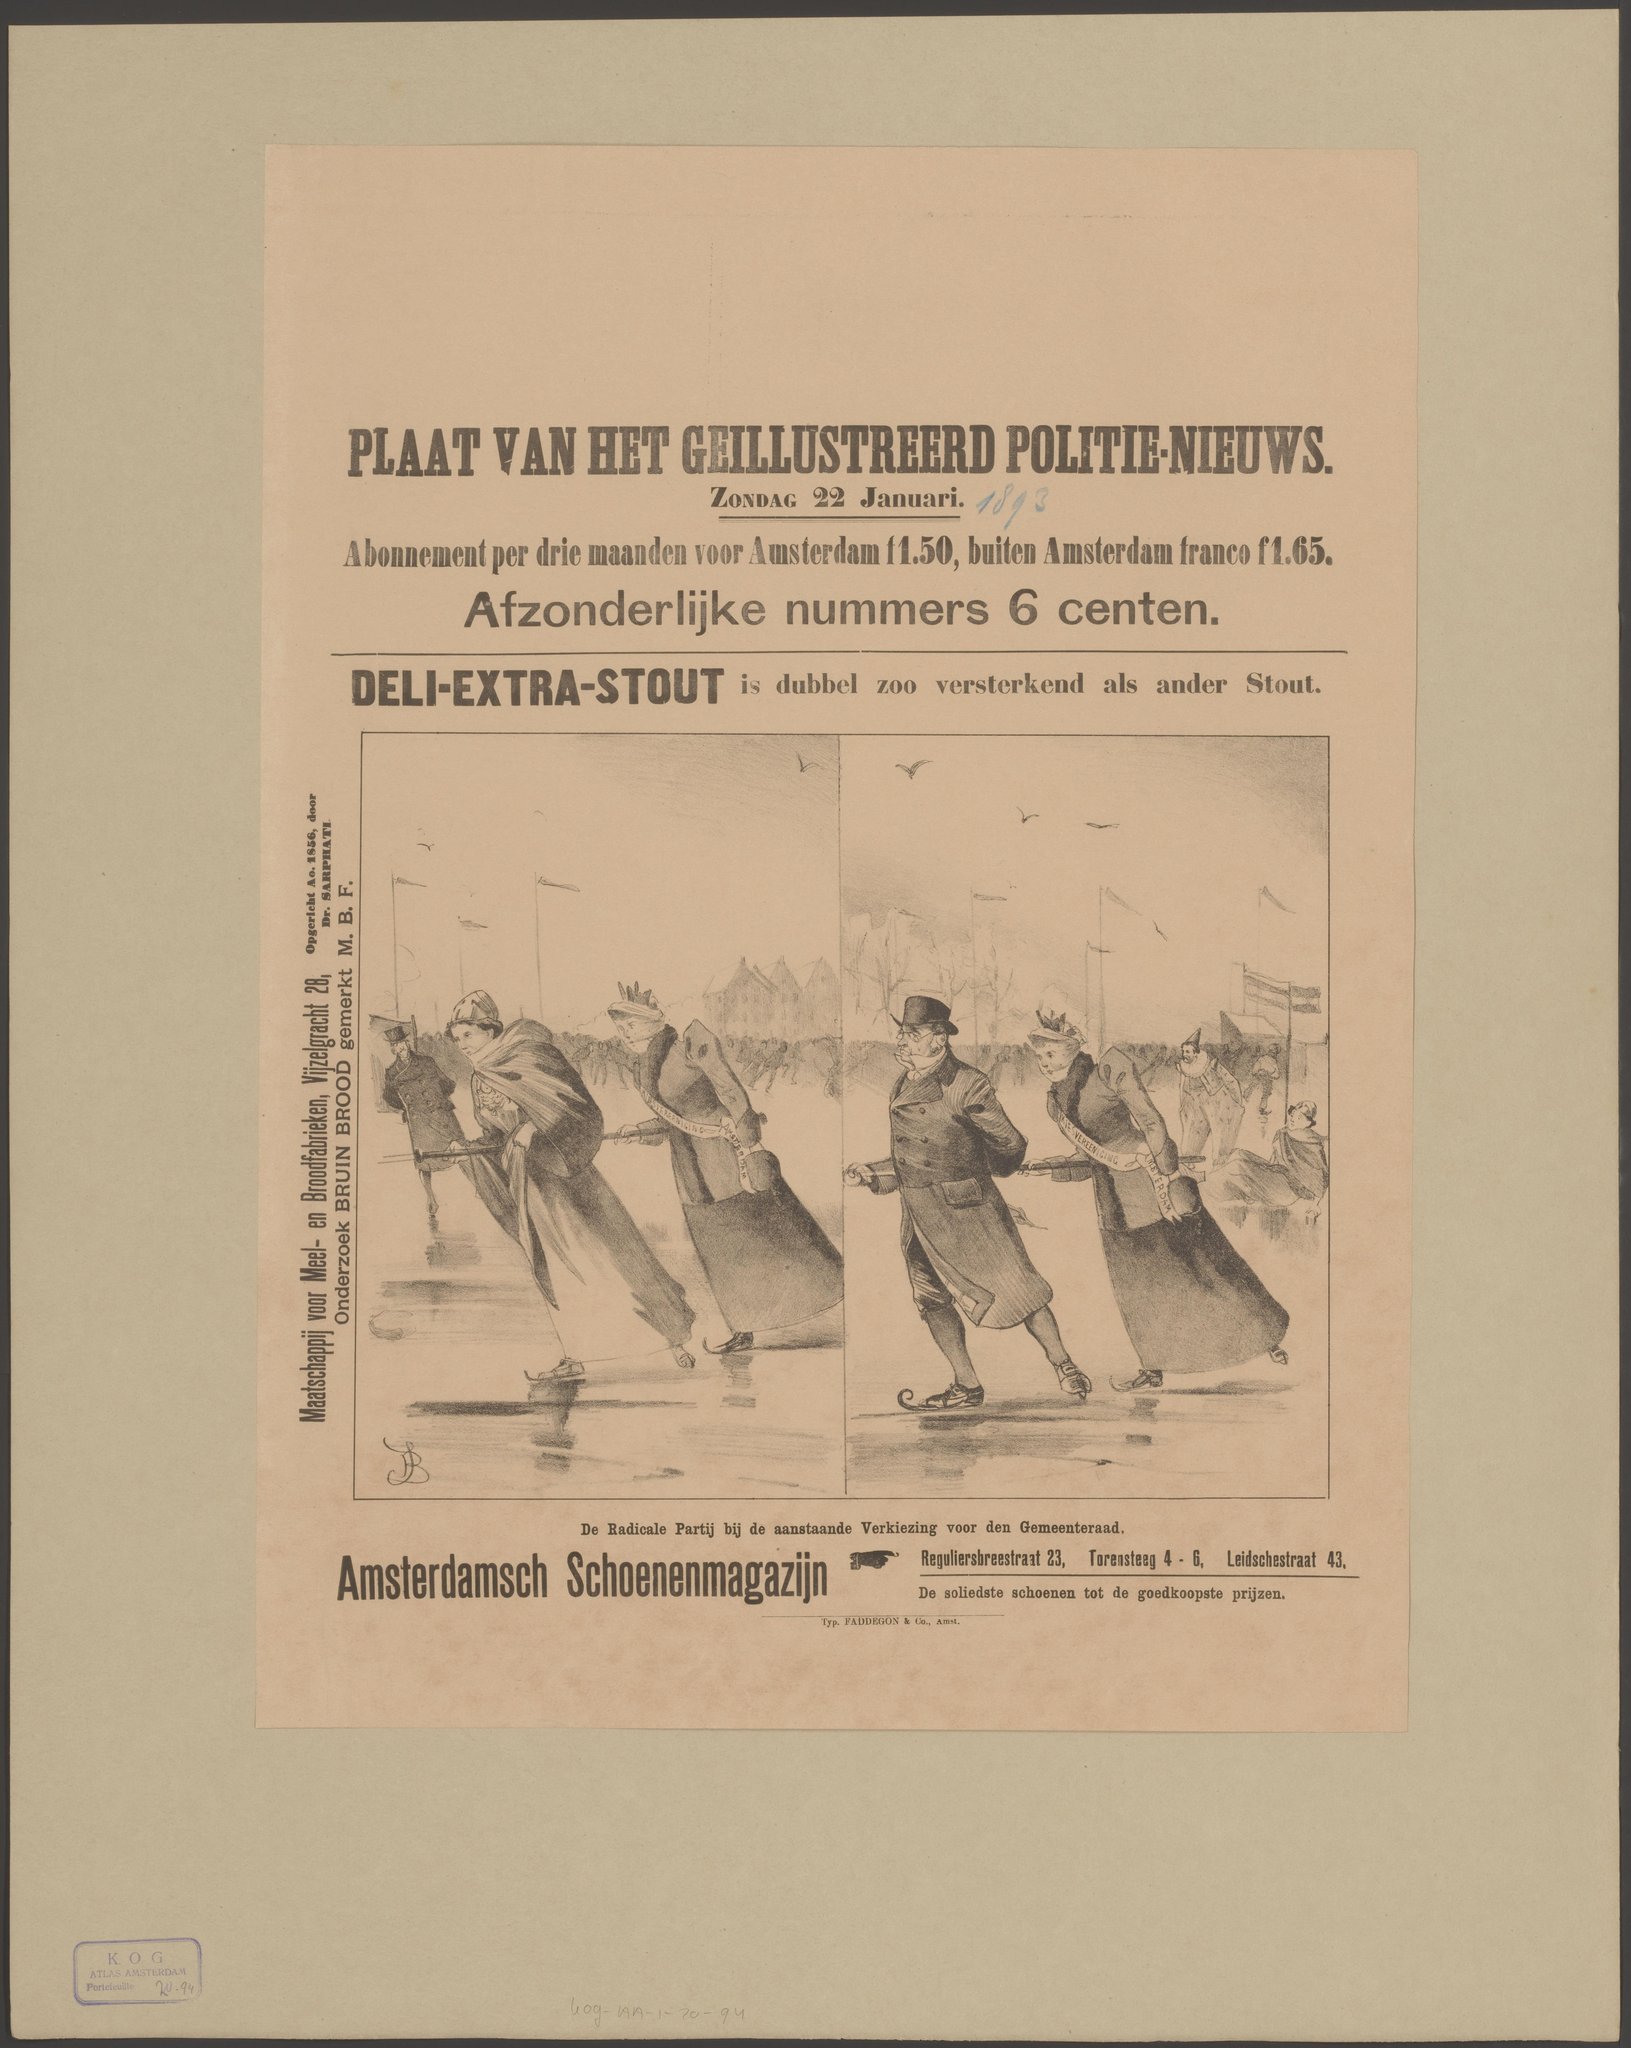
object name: cartoon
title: De Radicale Partij bij de aanstaande Verkiezing voor den Gemeenteraad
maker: johan braakensiek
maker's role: draughtsman, print maker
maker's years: 1858-1940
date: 1893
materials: paper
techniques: letterpress printing, lithograph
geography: netherlands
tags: winter landscape; landscape symbolizing winter (the four seasons of the year), skates (winter sports), clown, political caricatures and satires, amsterdam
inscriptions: collector's mark: Lugt 1641b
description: Gepubliceerd als bijvoegsel van 'Geïllustreerd Politie-Nieuws', 22 januari 1893.